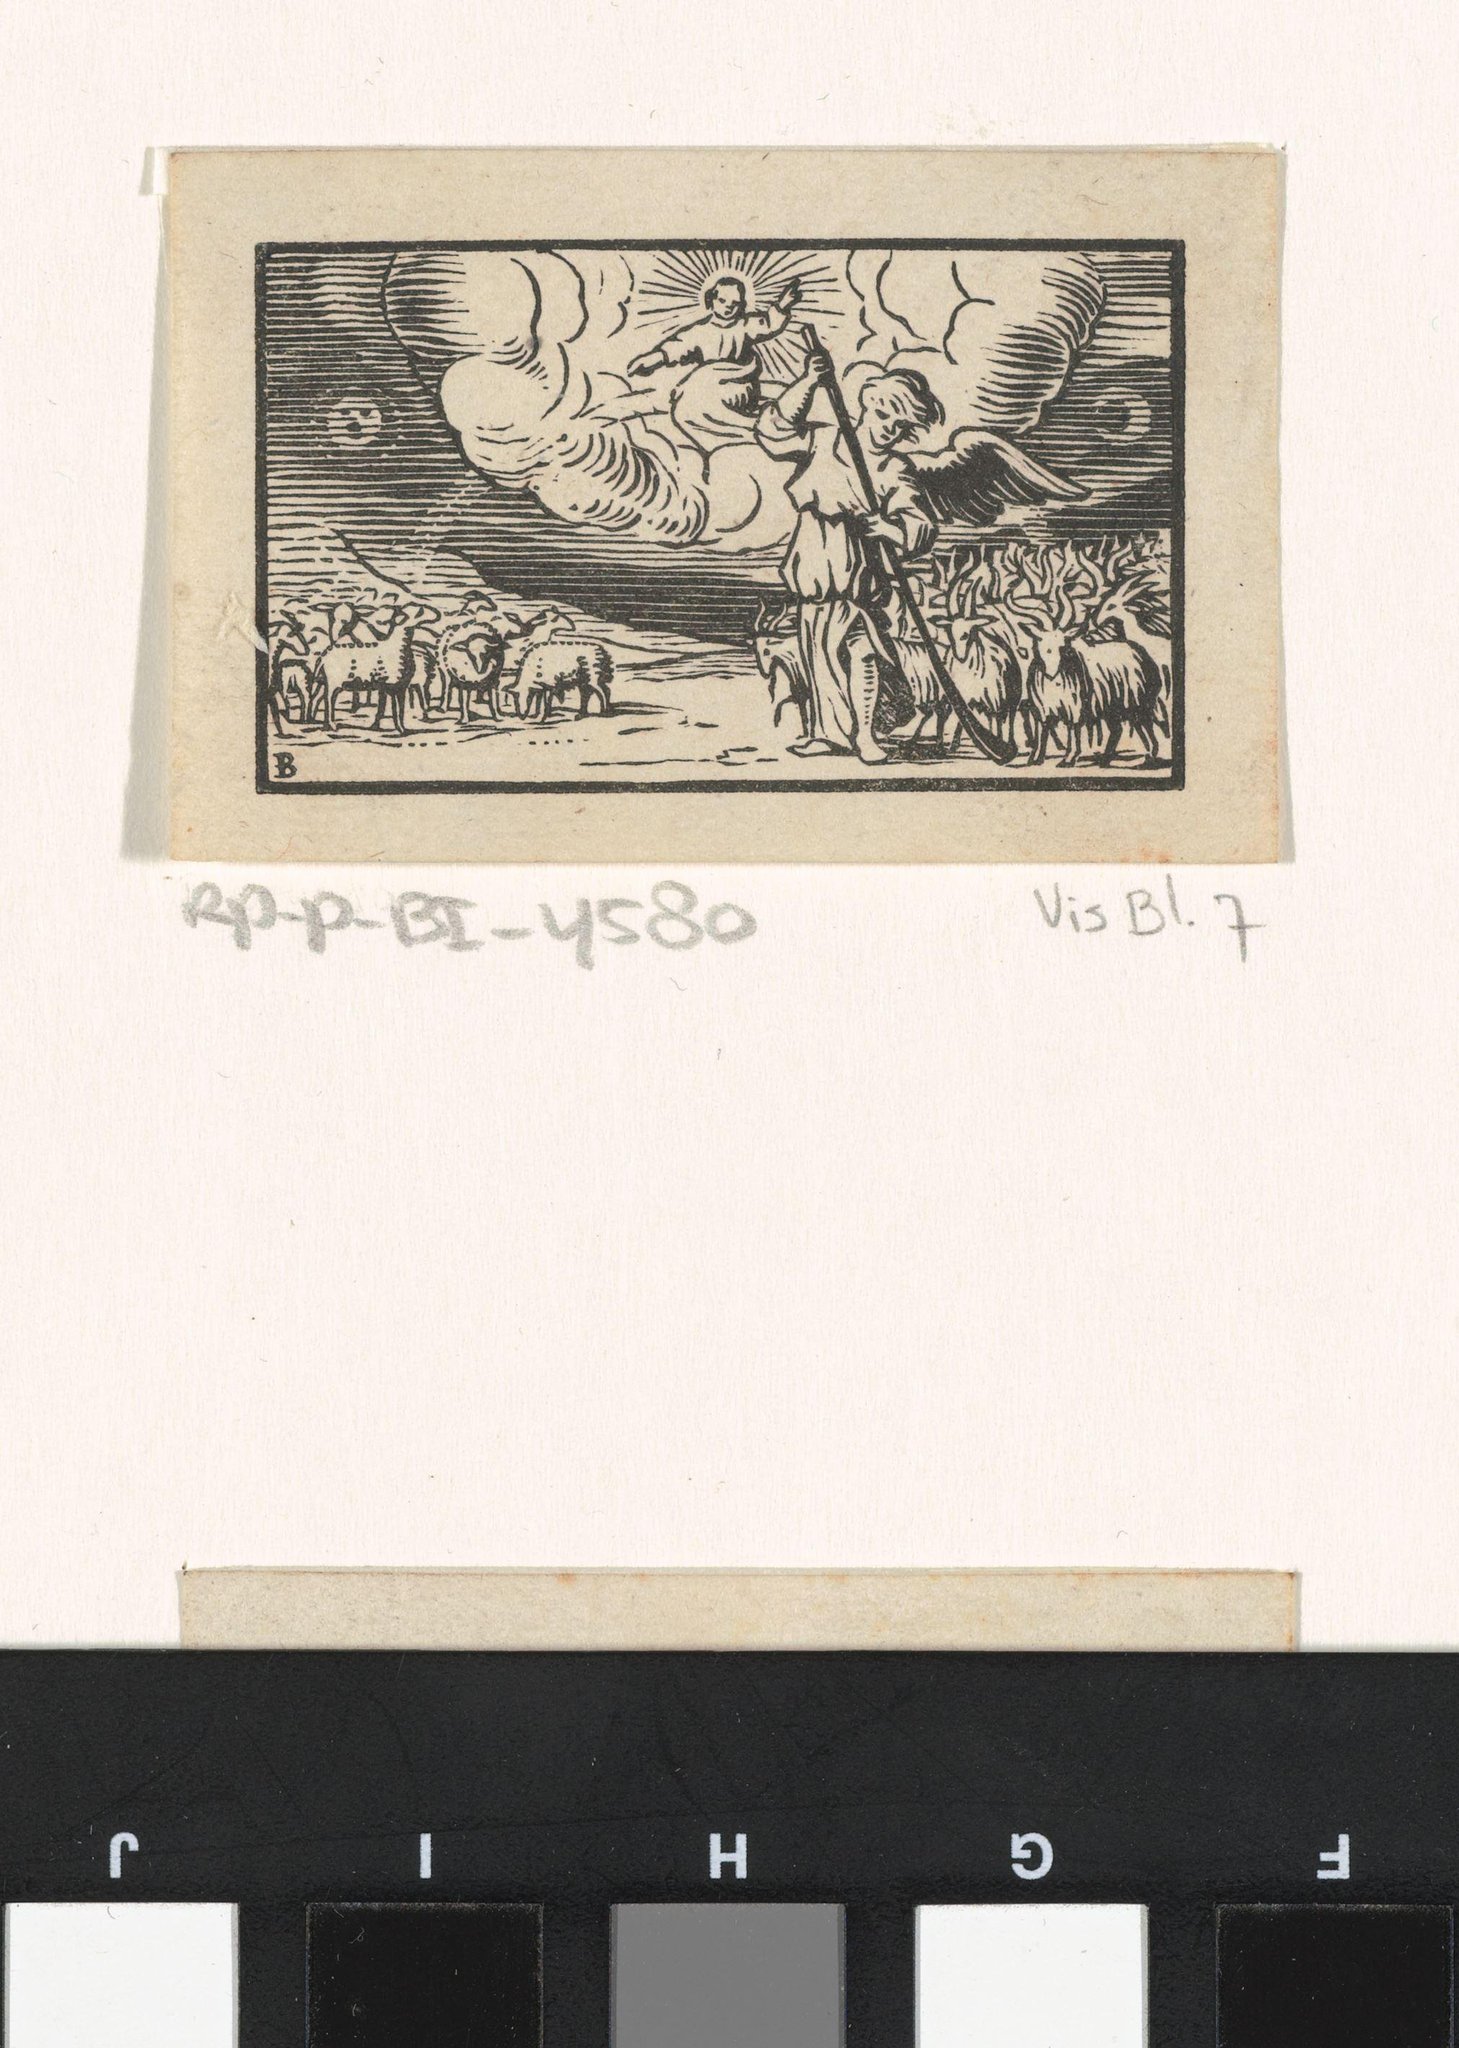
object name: print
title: Voorstellingen uit het Nieuwe Testament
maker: dirck de bray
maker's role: draughtsman, painter, print maker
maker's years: 1625-1694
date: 1635-1694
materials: paper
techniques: woodcut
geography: netherlands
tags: the announcement of christ's birth (luke 1:26-38)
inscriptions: collector's mark: Lugt 240